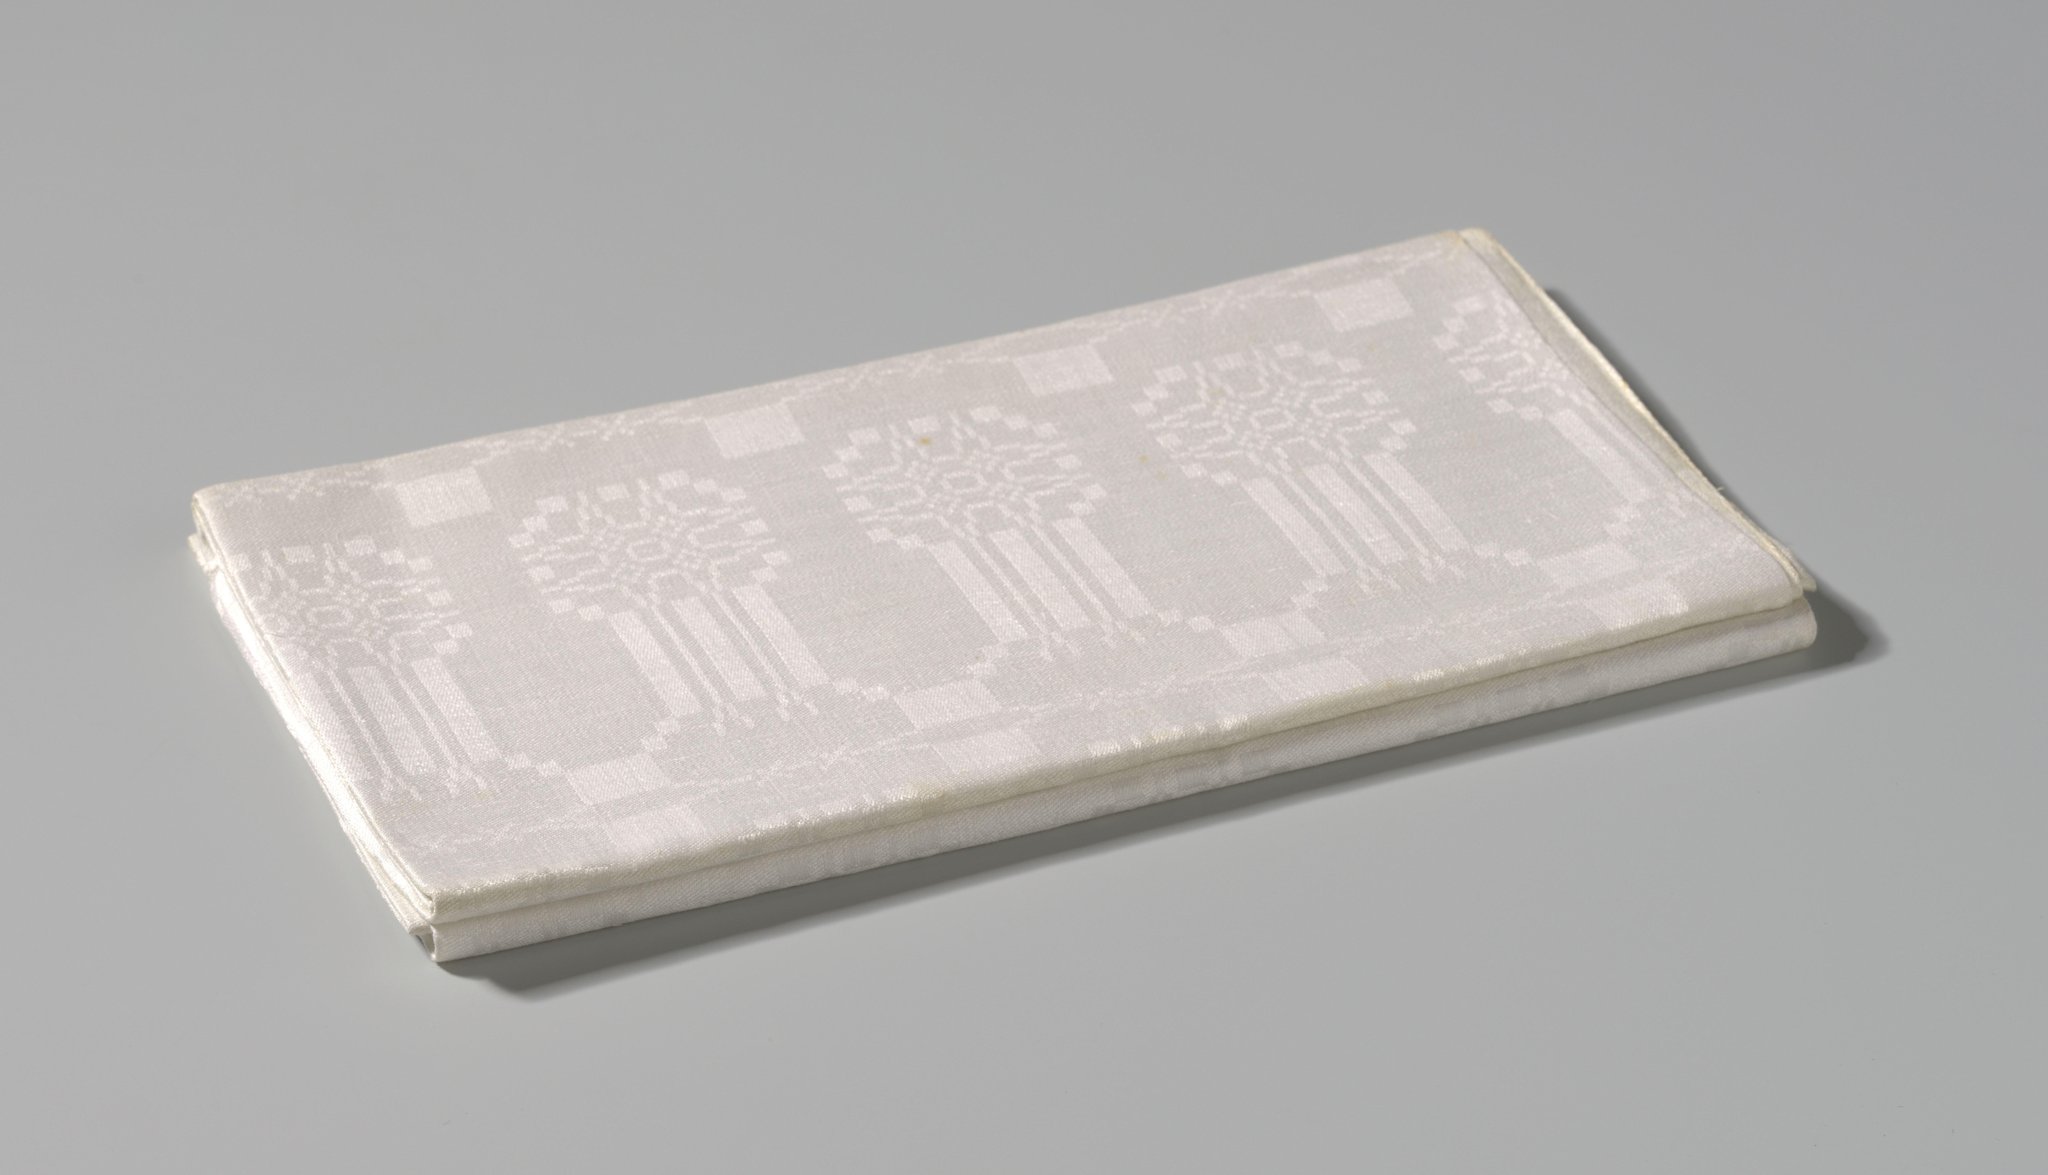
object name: napkin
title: Servet van linnen met pellenpatroon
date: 1750-1775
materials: linen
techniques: peeled fabric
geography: northern netherlands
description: wit linnen servet met pellen patroon, z.g. Oranjeboom, merk WO 20